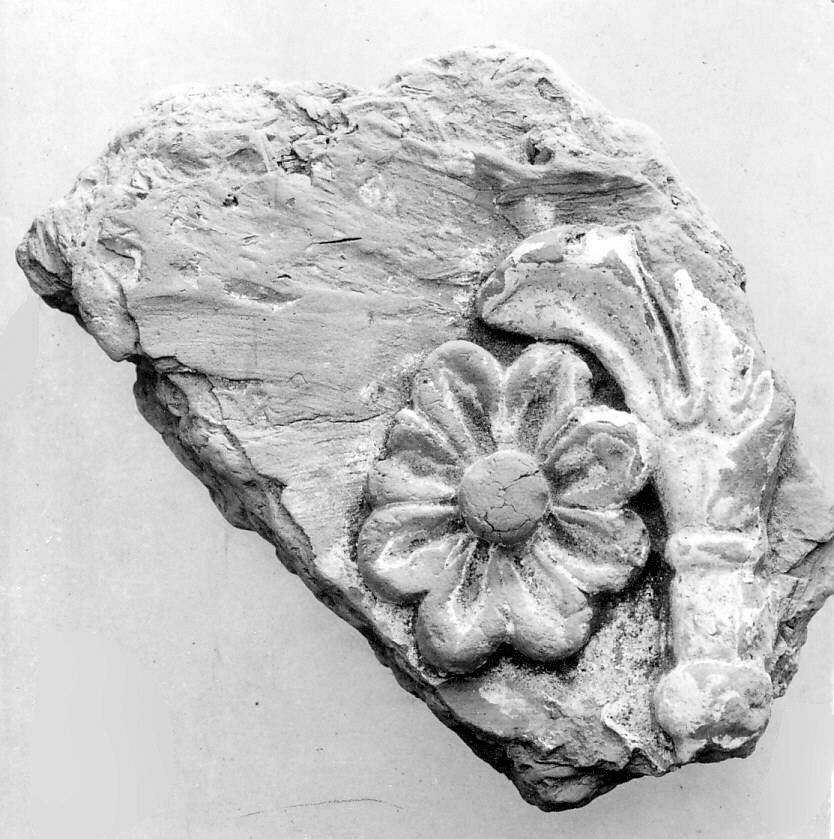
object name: relief fragment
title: Fragment of a Relief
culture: central asian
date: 201-700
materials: clay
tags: flowers